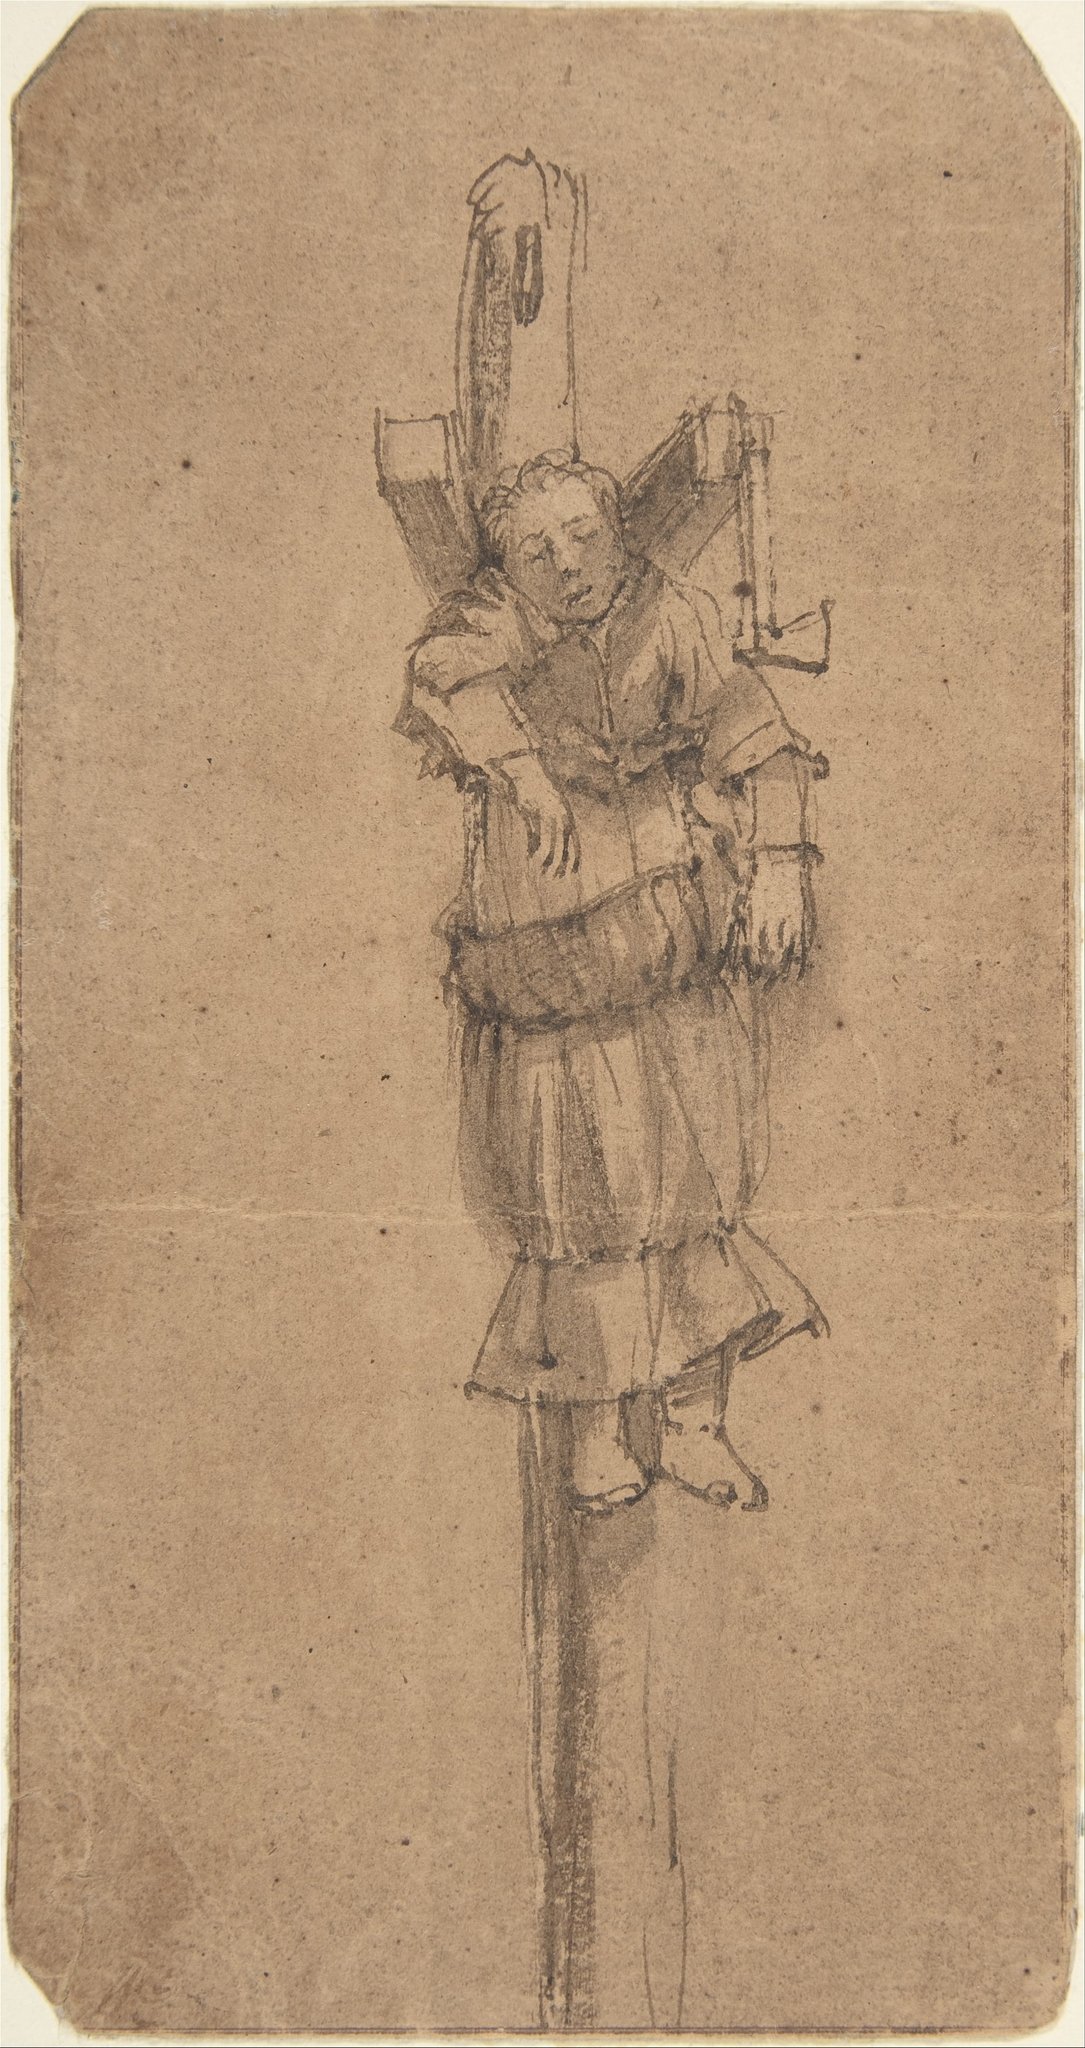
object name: drawing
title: Elsje Christiaens Hanging on a Gibbet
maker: rembrandt van rijn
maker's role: artist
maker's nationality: dutch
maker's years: 1606-1669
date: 1664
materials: ink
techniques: brush, pen, wash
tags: girls,axes